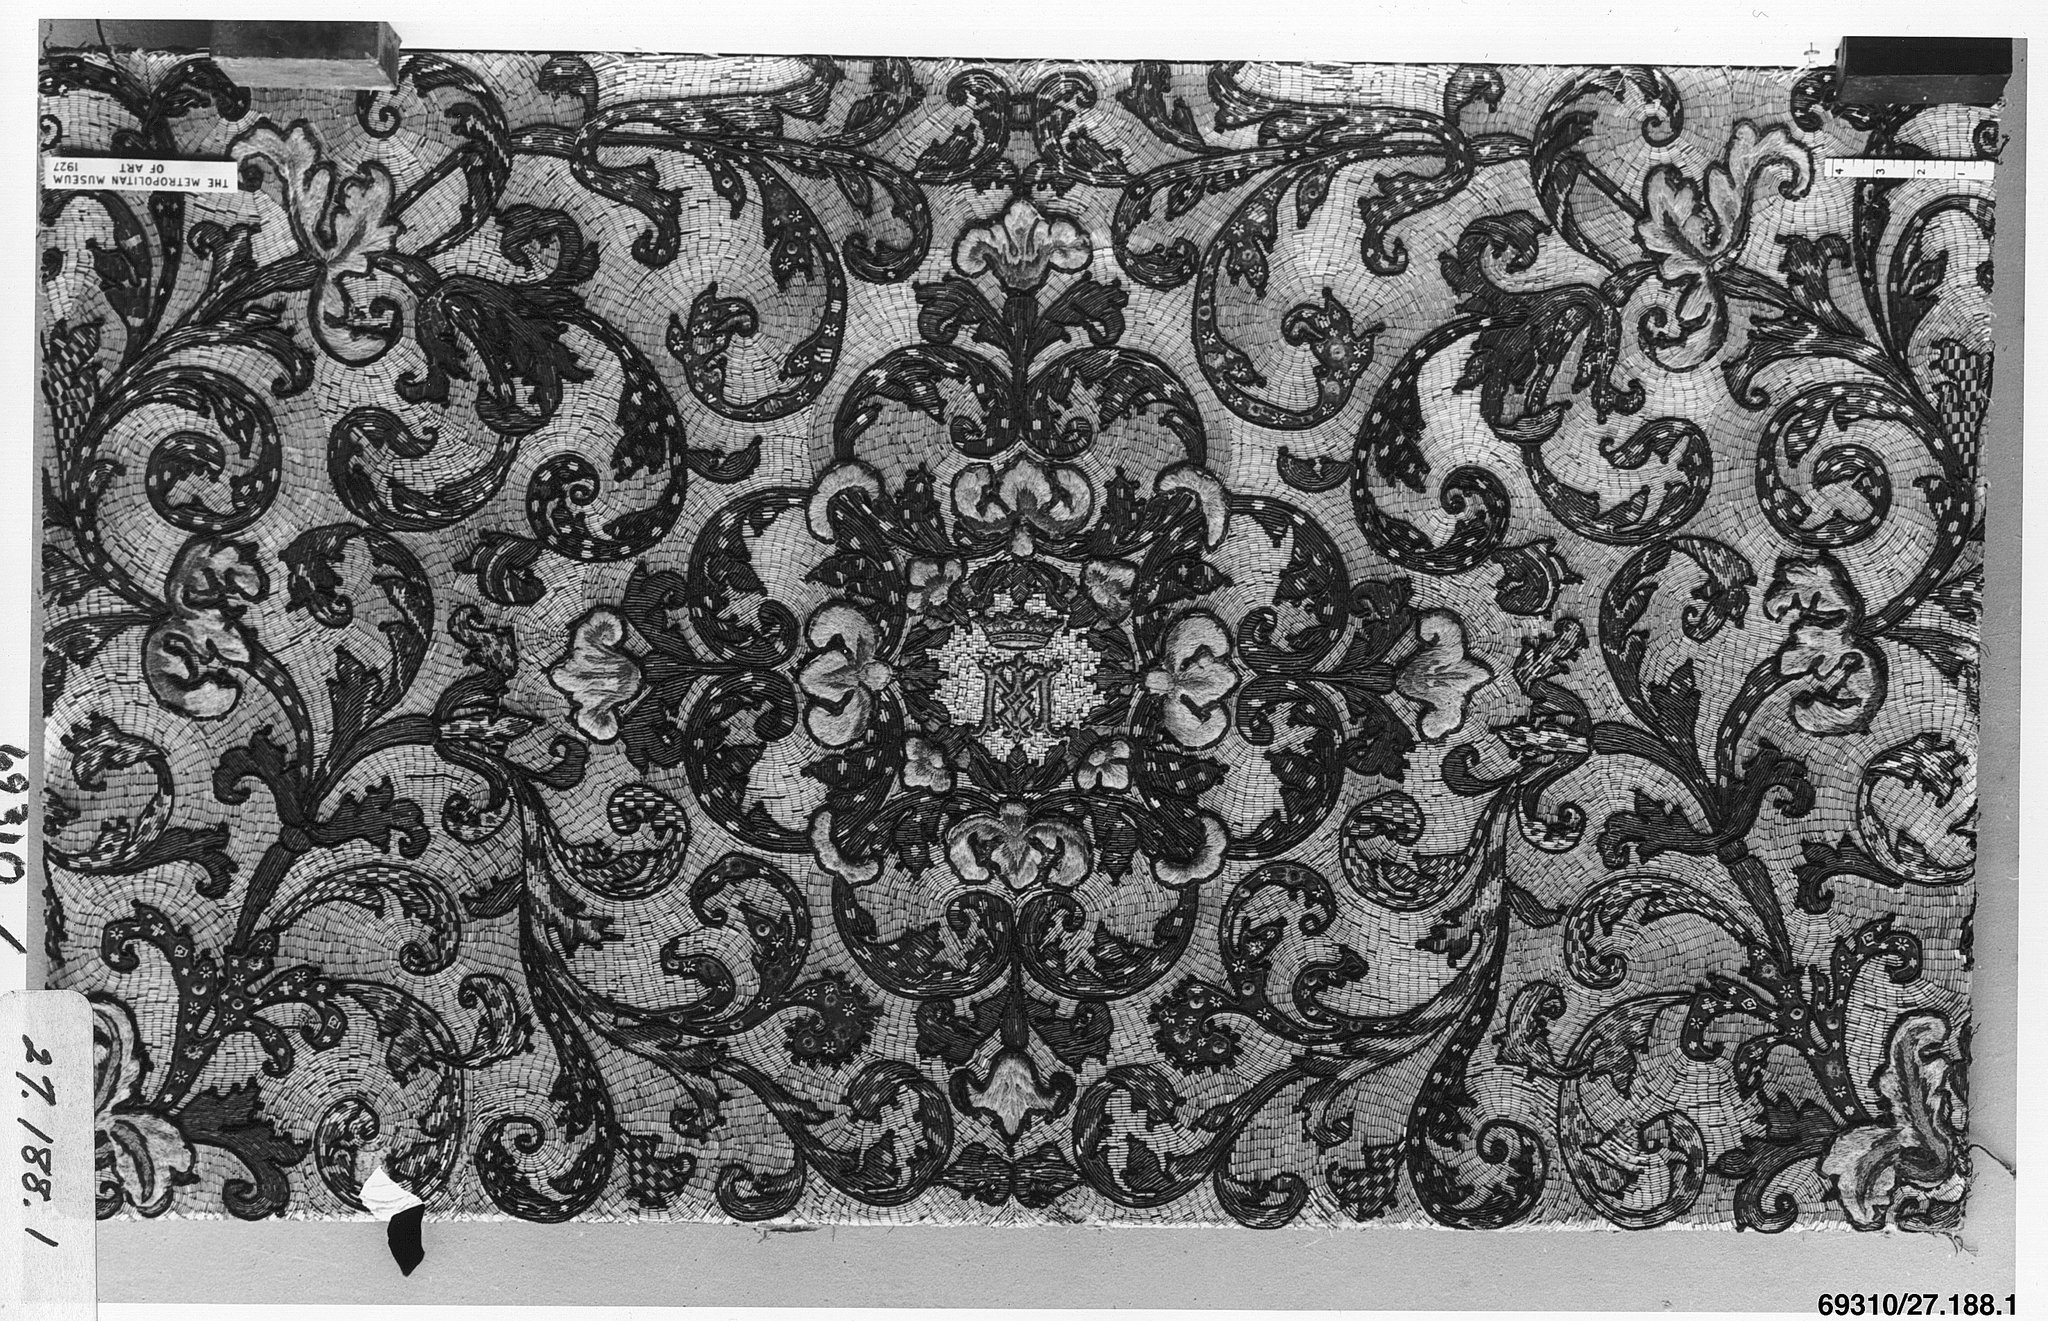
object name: altar frontal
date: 1601-1700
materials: linen, silk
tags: flowers